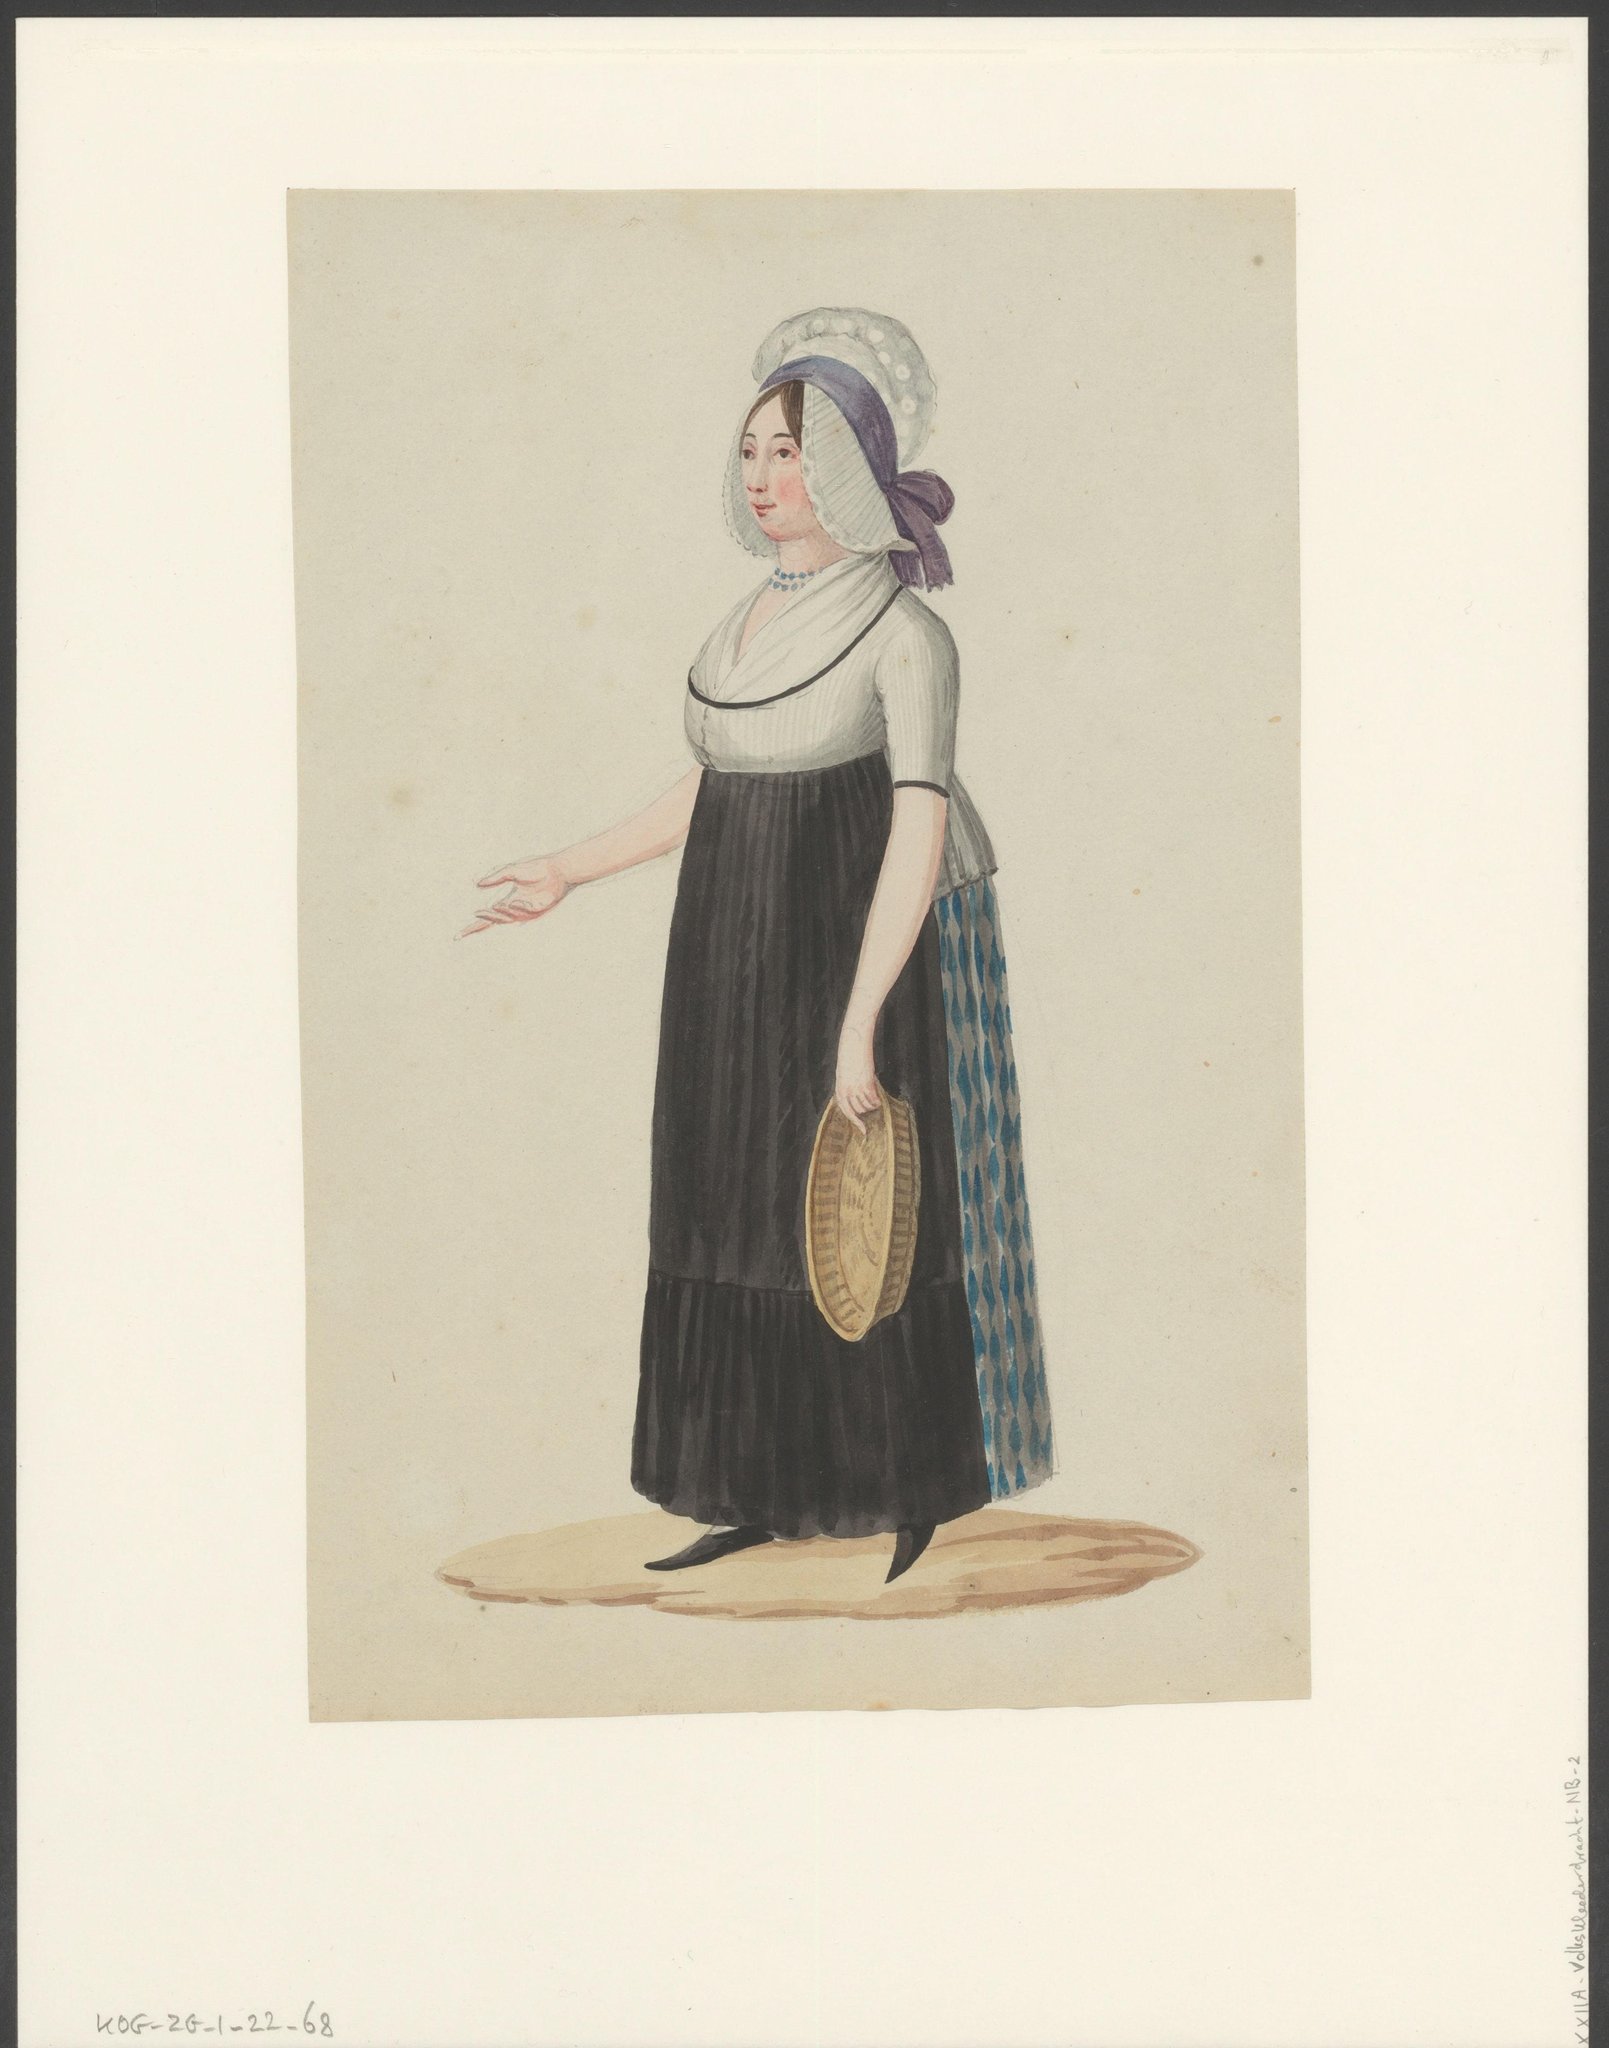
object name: watercolor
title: Staande vrouw van Brabant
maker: Anonymous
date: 1775-1800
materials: paper, watercolor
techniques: brush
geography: netherlands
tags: clothes, costume (+ women's clothes), folk costume, regional costume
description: Staande vrouw met een mand in de hand, naar links, in klederdracht van Noord-Brabant. Onderwerpsrubrieken binnen de Atlas Zeden en Gewoonten: De Kleeding, Volkskleederdracht.